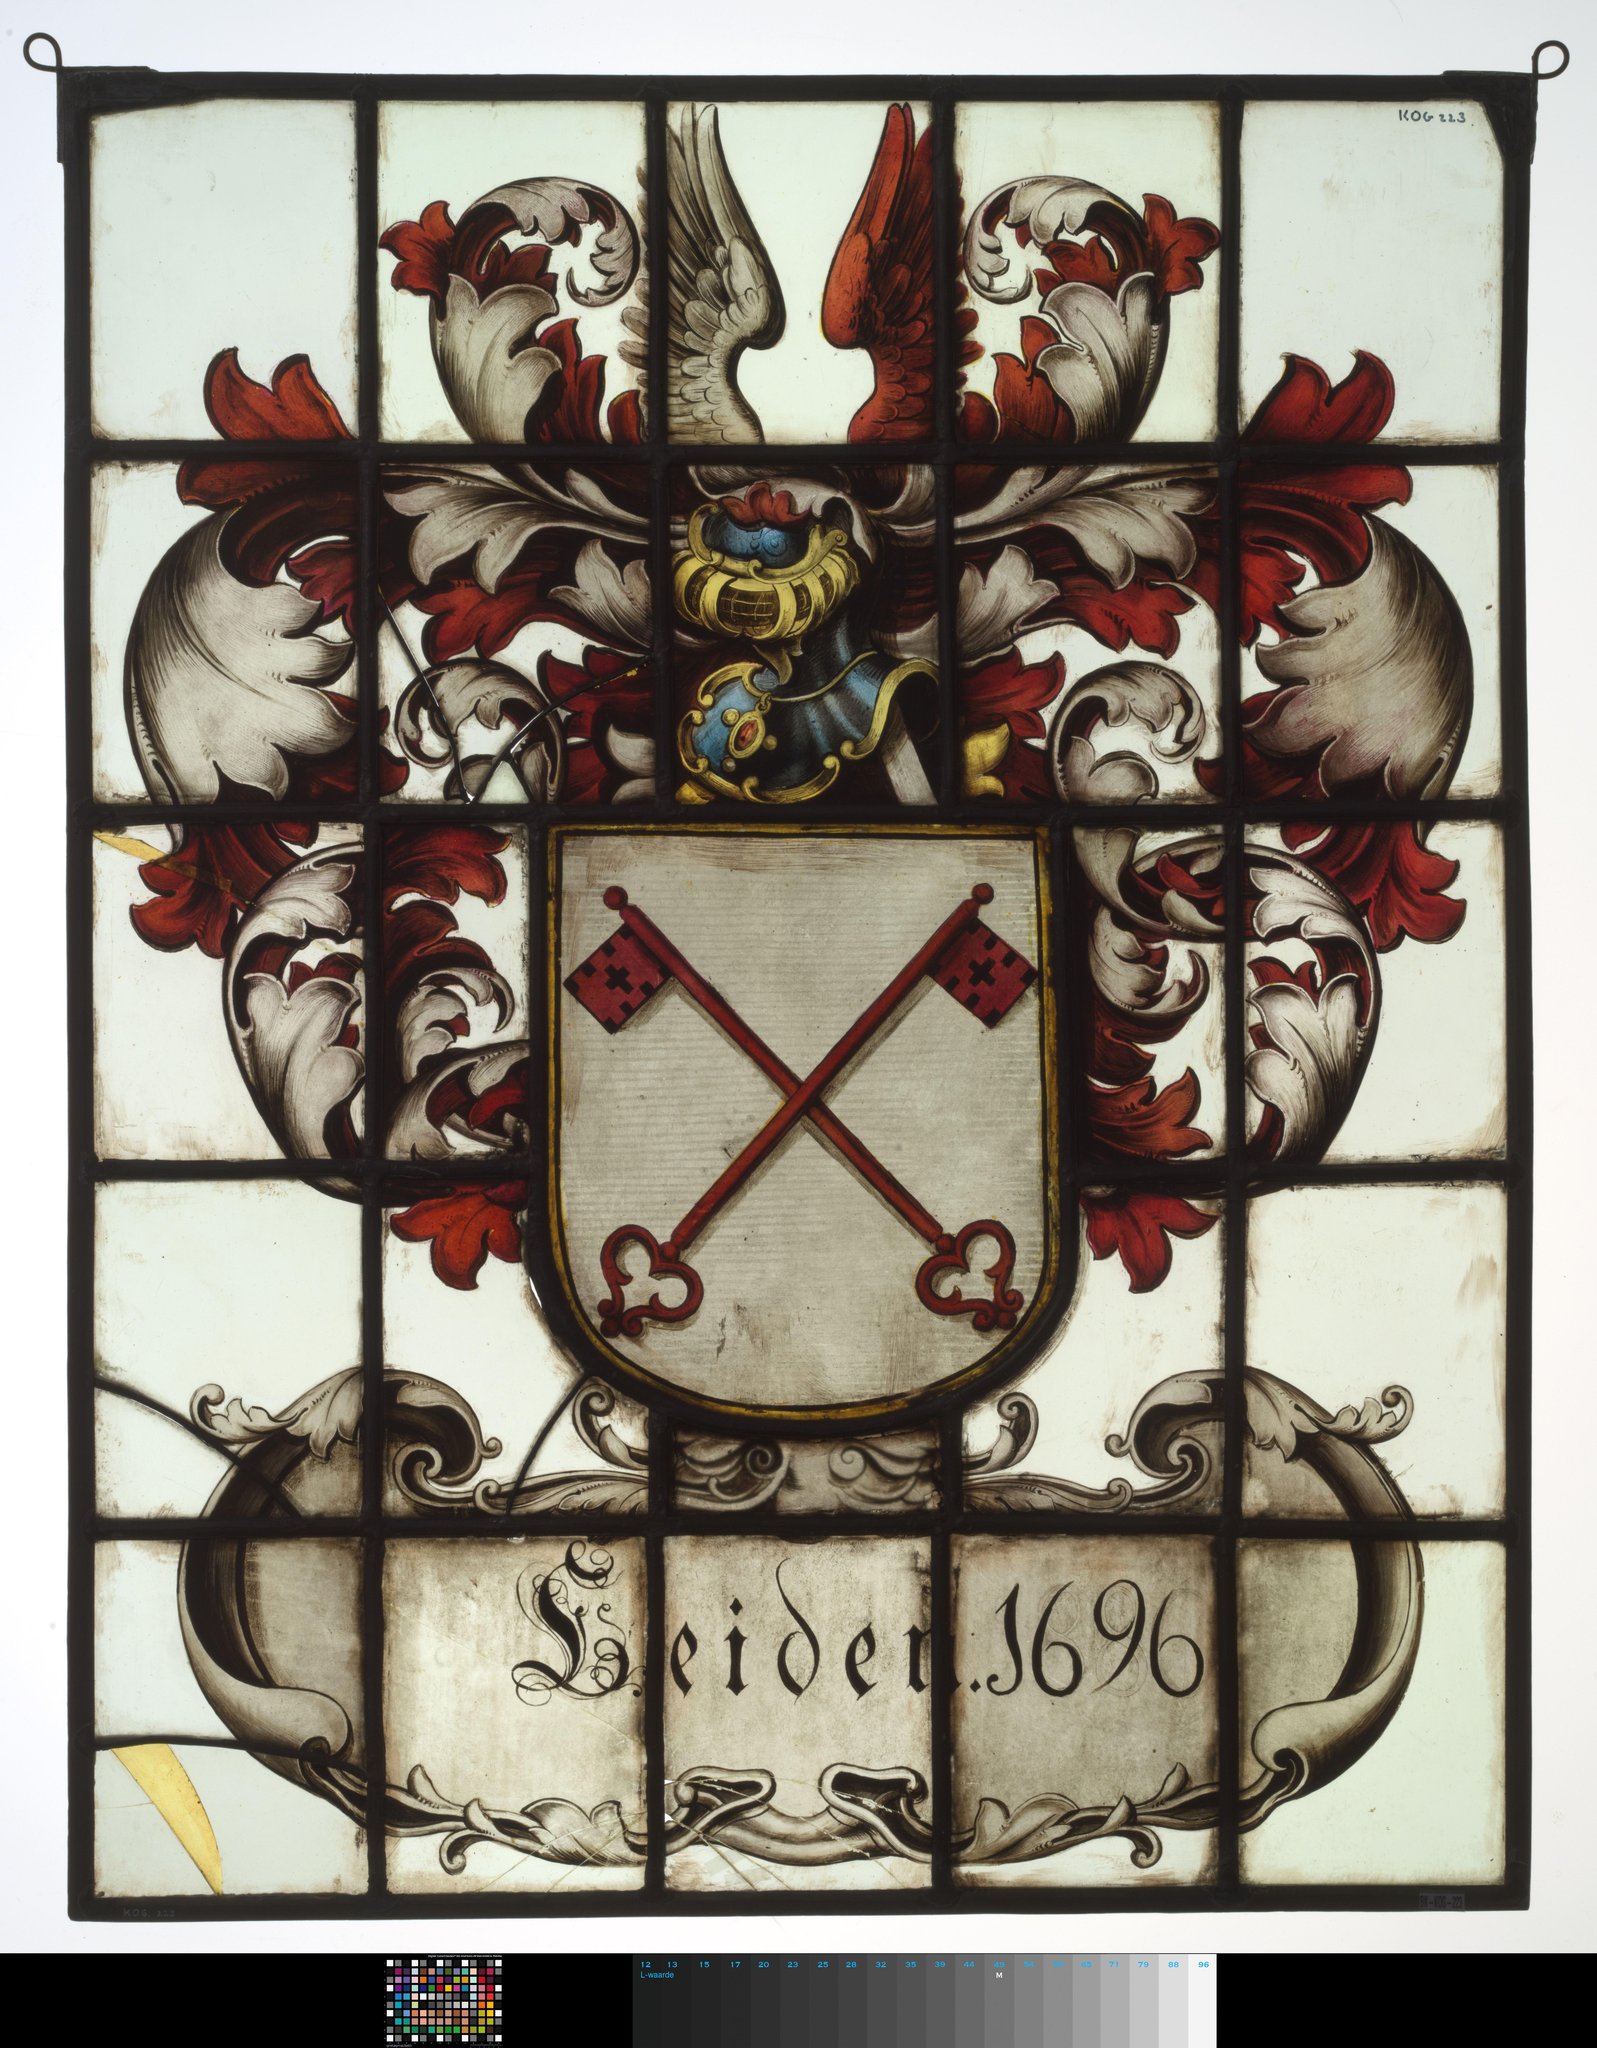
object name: wapenruit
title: Ruit met wapen van Leiden en onderschrift "Leiden 1696"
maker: Anonymous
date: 1696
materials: glass, lead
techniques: leading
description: Gebrandschilderde ruit met het wapen van Leiden. Met onderschrift "Leiden, 1696". Opmerking: Zat samen met inv nr. BK-KOG-118 in één ruit (zie foto). Behoort tot dezelfde serie als BK-KOG-220, 221 en 226. Afkomstig uit de Ned. Herv. Kerk te Twisk.